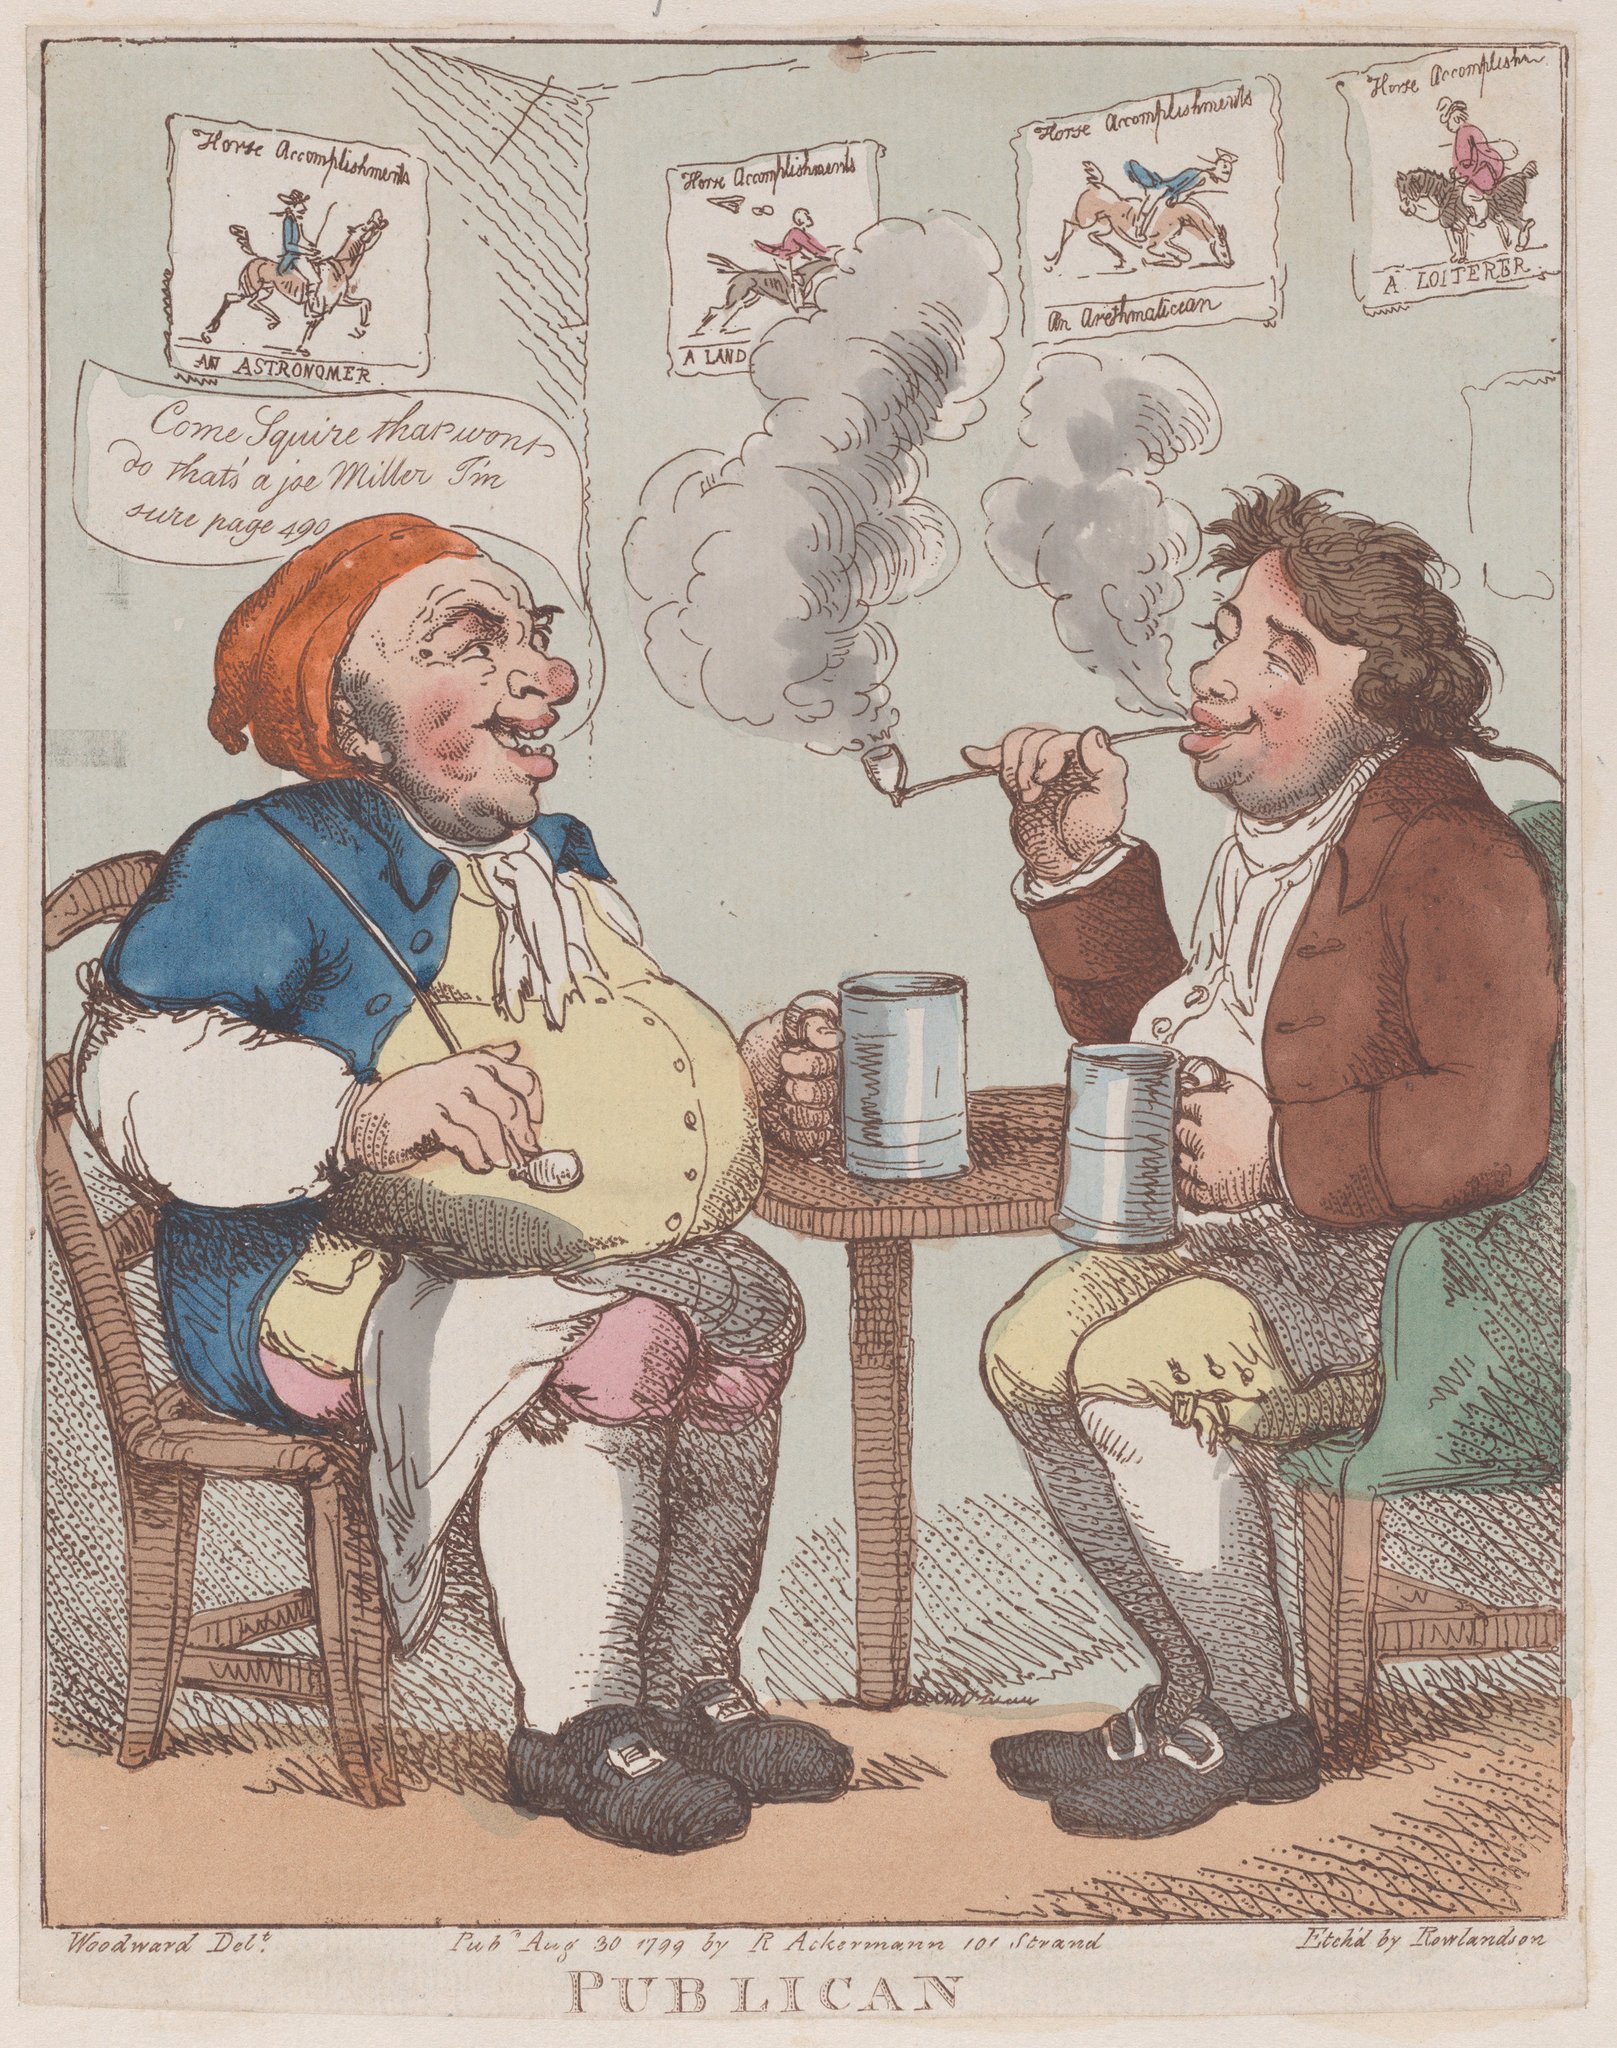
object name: print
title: Publican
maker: thomas rowlandson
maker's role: artist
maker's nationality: british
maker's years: 1757-1827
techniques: etching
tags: satire,men,smoking,drinking